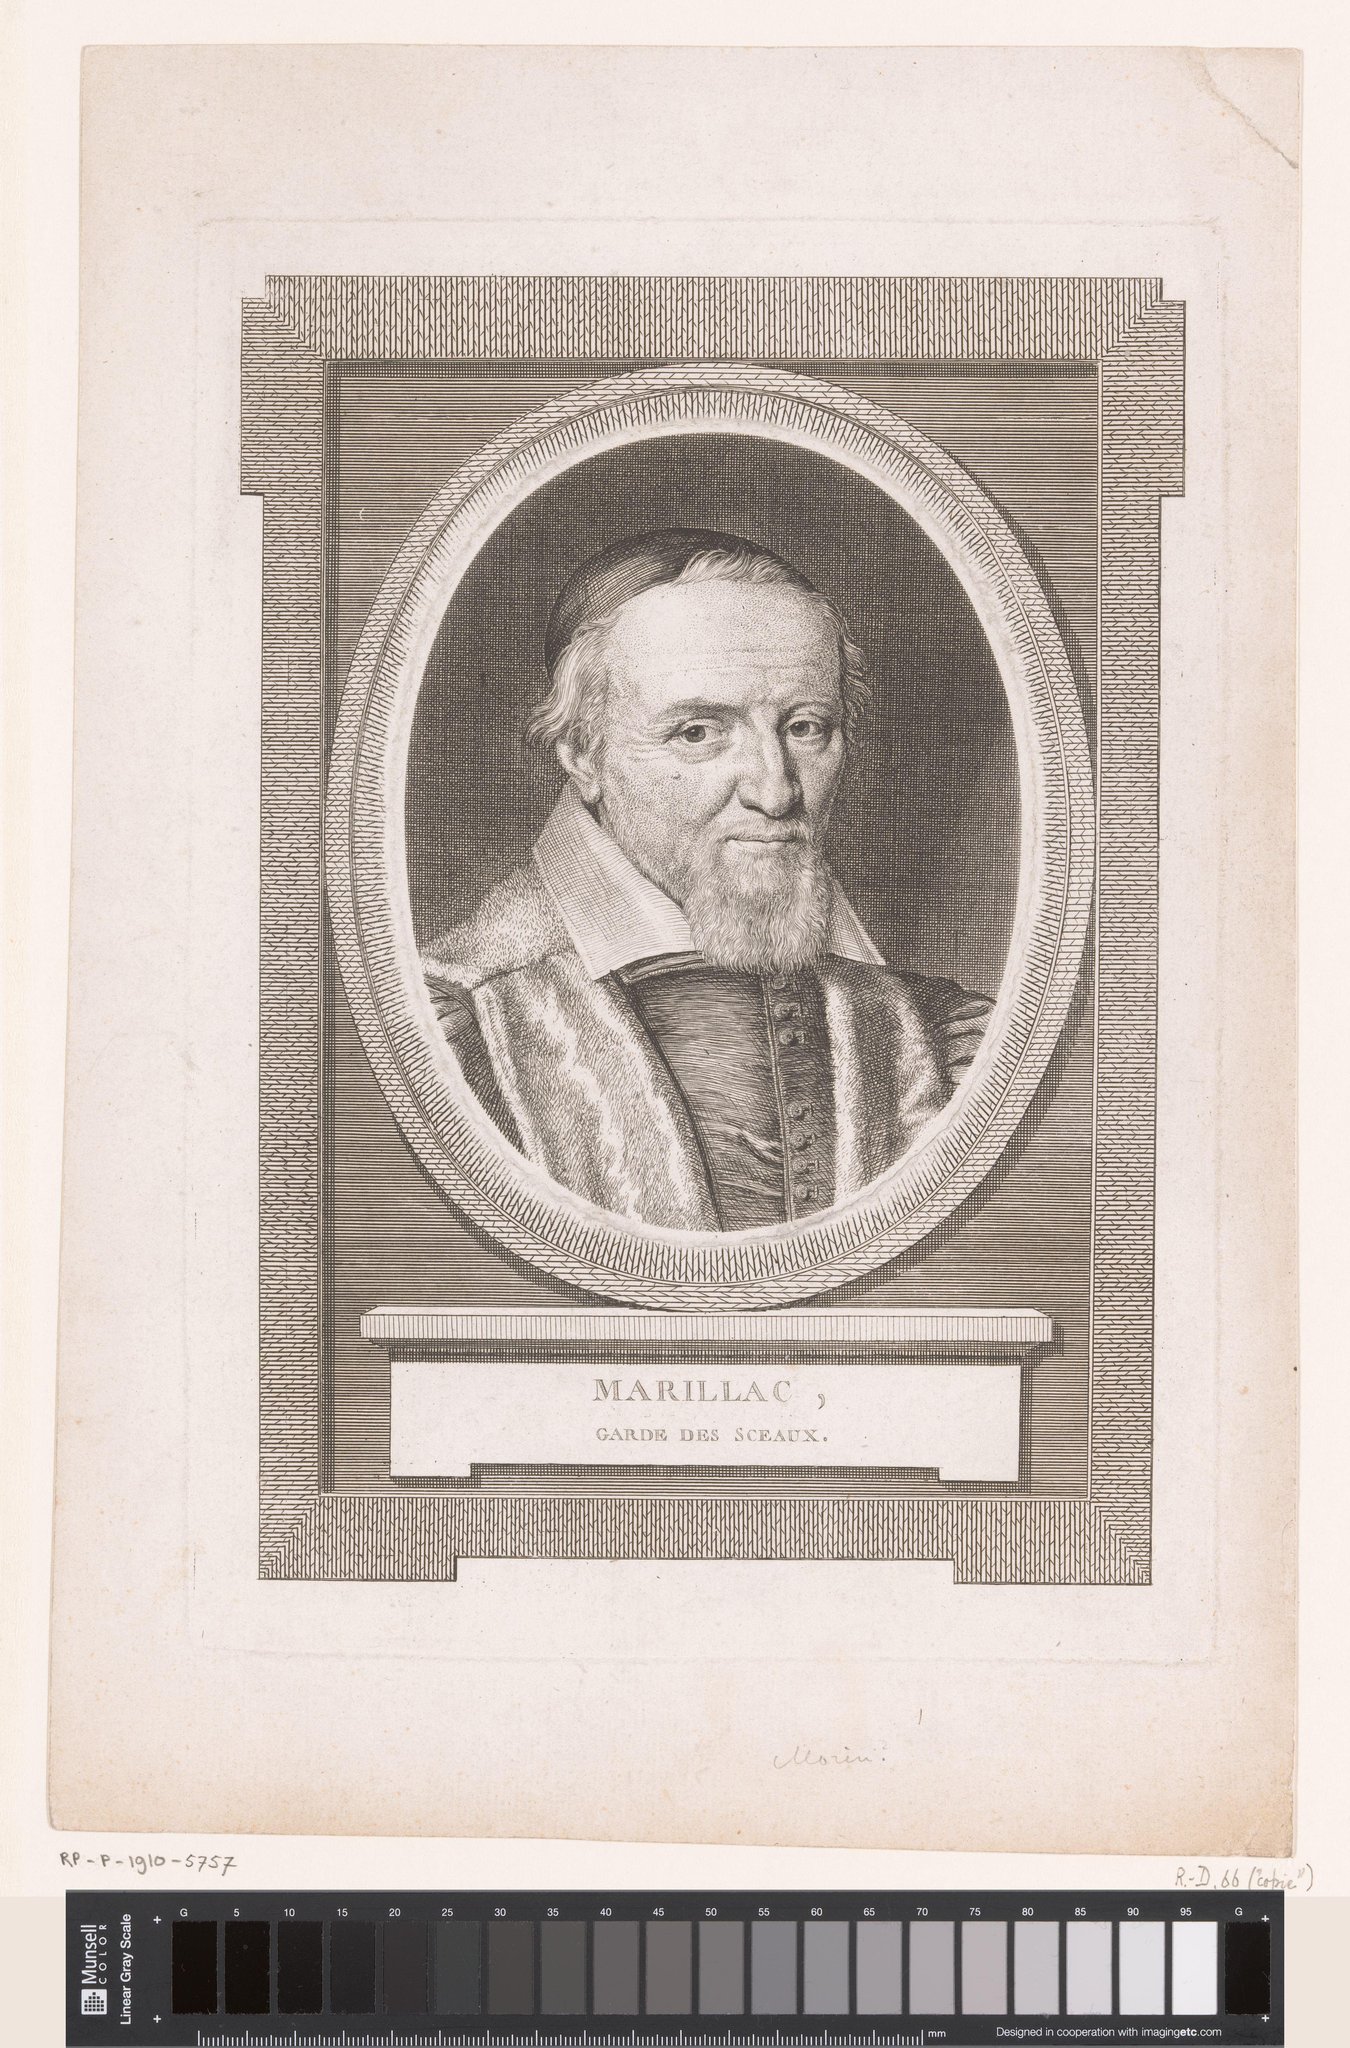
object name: print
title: Marillac, Garde des Sceaux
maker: jean morin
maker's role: print maker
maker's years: 1605-1650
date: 1630-1790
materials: paper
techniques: engraving, etching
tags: historical persons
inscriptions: collector's mark: Lugt 2228